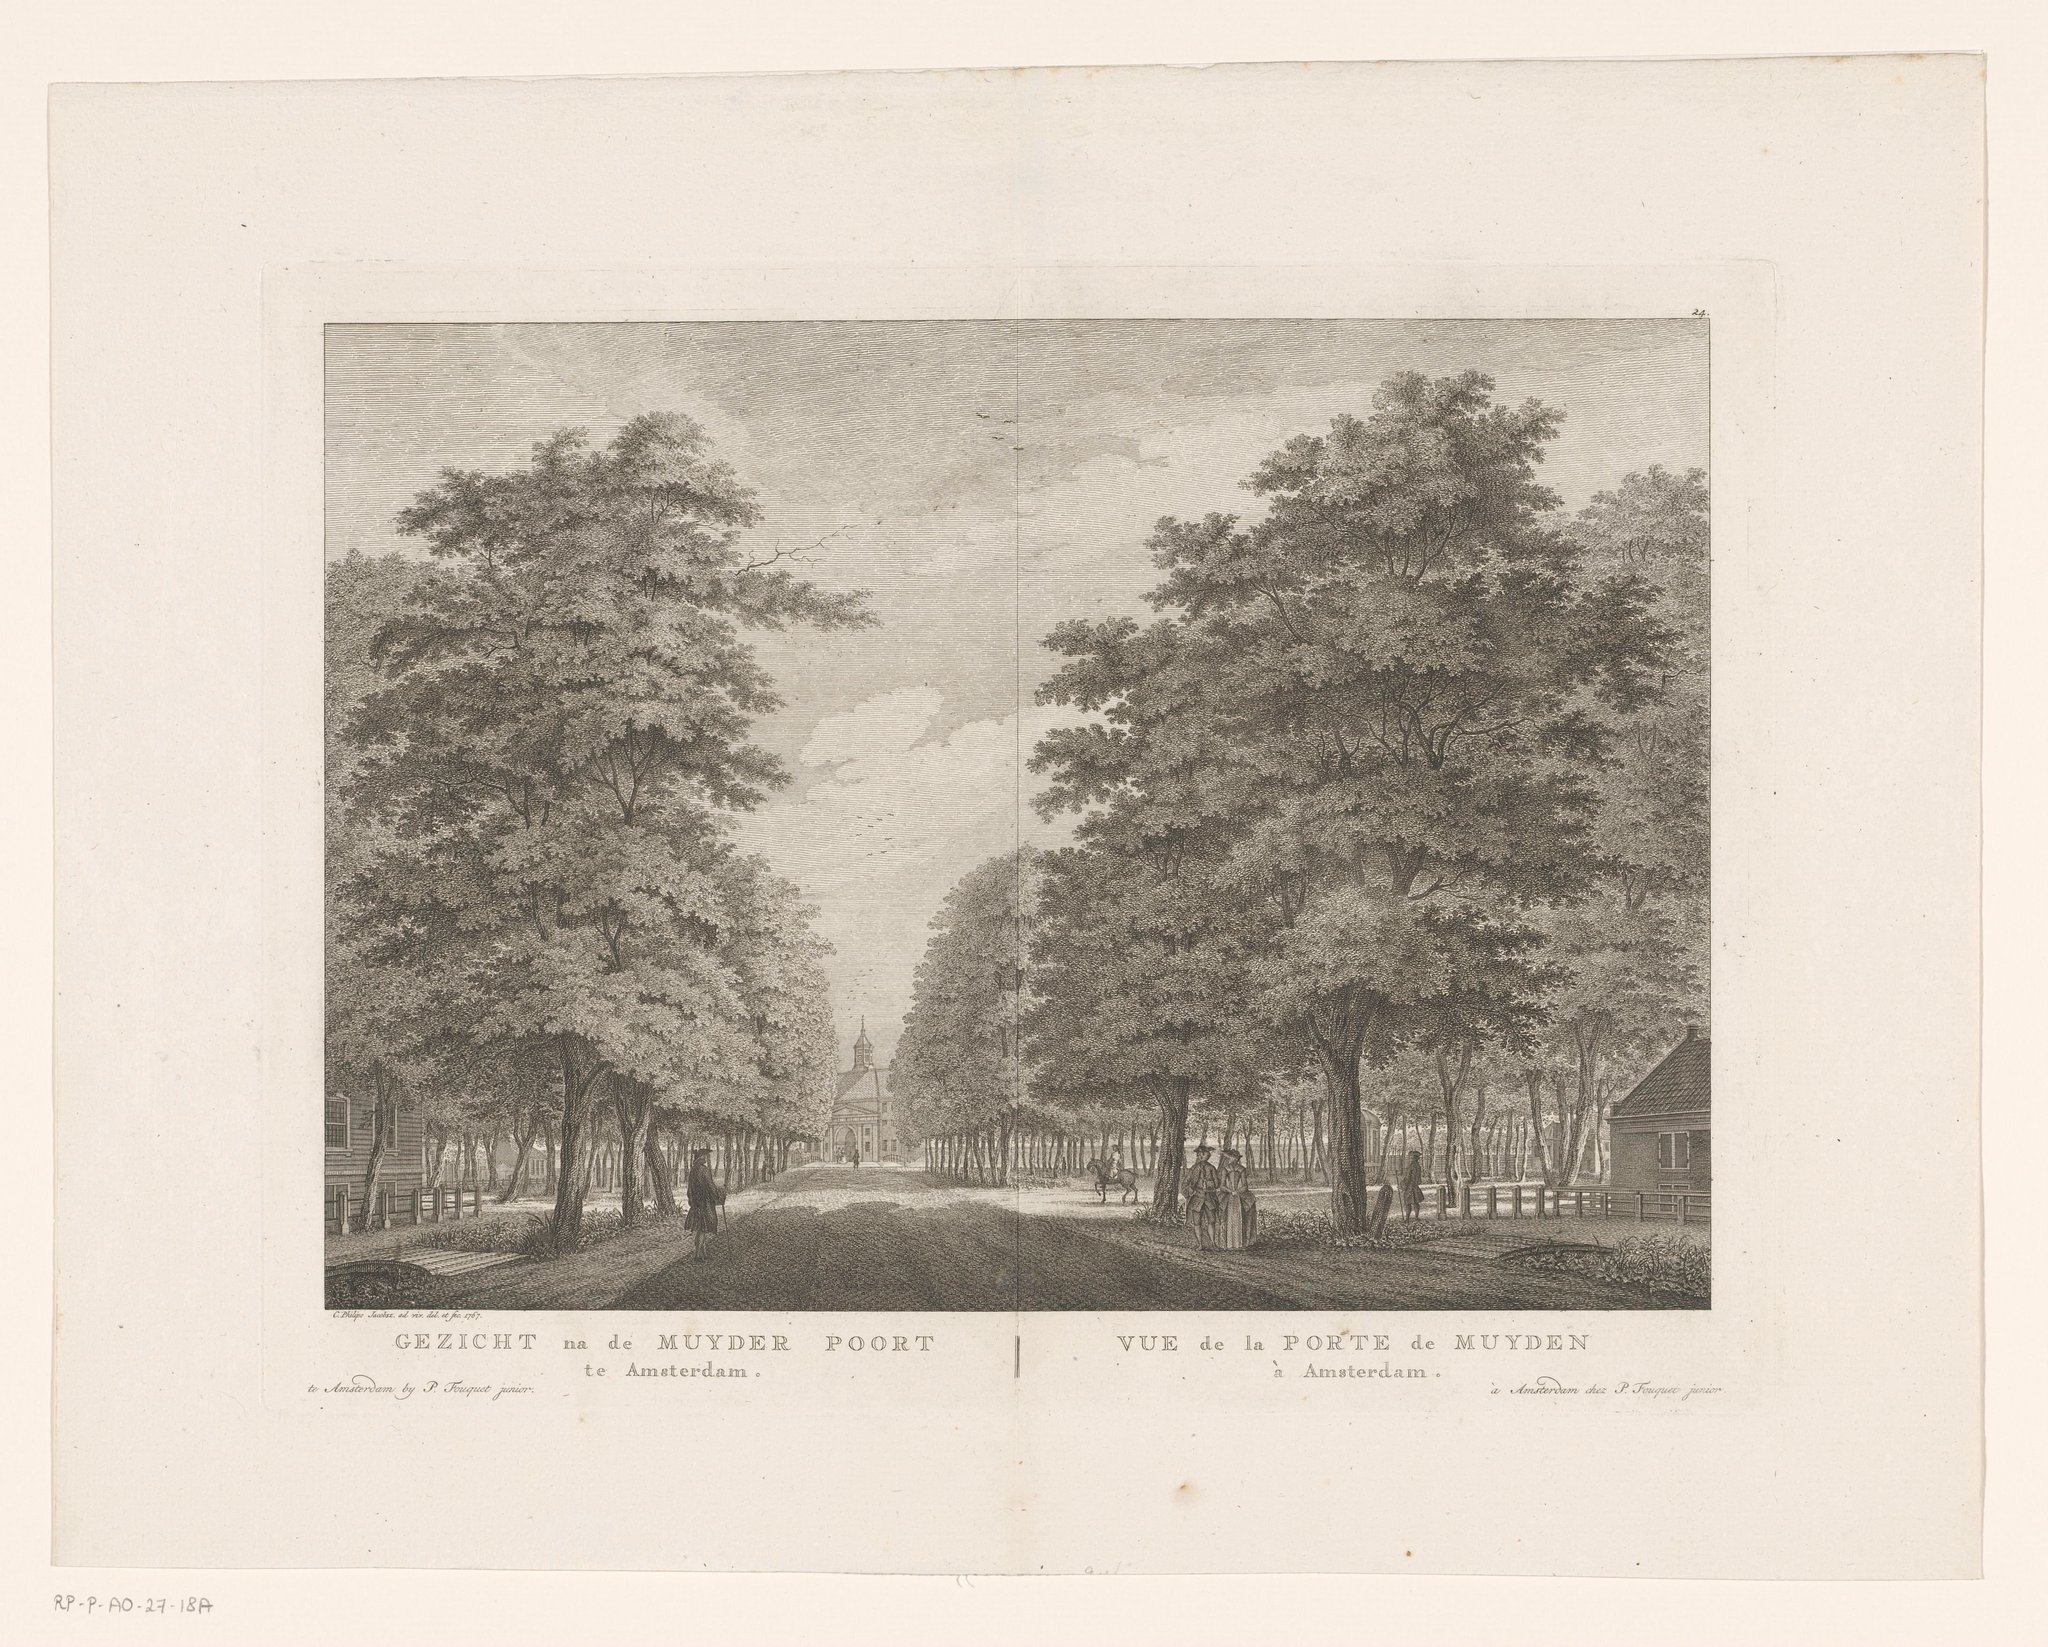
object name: print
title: Gezicht na de Muyder Poort te Amsterdam / Vue de la Porte de Muyden à Amsterdam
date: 1767-1783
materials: paper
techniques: engraving, etching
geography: amsterdam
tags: road, path, city-gate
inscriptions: collector's mark: Lugt 2228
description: Deze prent is ook gebruikt in de zogenaamde Atlas van Fouquet.* Pierre Fouquet gaf vanaf 1760 stadsgezichten van Amsterdam - naar tekeningen van verschillende kunstenaars, gemaakt door verschillende prentmakers - uit. Deze prenten werden aanvankelijk los of in series verkocht. Zoals toen gebruikelijk kon de koper de prenten zelf laten inbinden. Hiertoe gaf Fouquet tussen 1778 en 1783 een titelblad, plattegrond en inhoudsopgave van de tot dusver 100 uitgegeven prenten uit (1). Gezien de inhoud afhankelijk was van wat de koper had verzameld verschilt de inhoud van de verschillende bewaarde Fouquetatlassen onder deze titel sterk. Ook zijn er exemplaren bekend waar tevens andere prenten aan zijn toegevoegd. Omdat er behoefte bleek aan uitleg bij de platen werd in 1783 een nieuwe versie van de atlas uitgegeven, aangevuld met tekst en twee prenten. De aangegeven volgorde veranderde maar de platen van de al eerder uitgegeven prenten bleven ongewijzigd. Deze uitgave werd in opdracht van Fouquet gedrukt bij Daniël Jean Changuion en Petrus den Hengst (2). Een tiental platen werd bijgewerkt en verscheen, met nieuw impressum, in het vervolg van Wagenaars geschiedenis van Amsterdam, uitgeven door Petrus Conradi en Folkert van der Plaats (3). Een aantal jaar na het overlijden van Fouquet kwam Evert Maaskamp met een nieuwe uitgave van de atlas, met verbeterde tekst en toevoeging van twee prenten. Op alle platen verwijderde hij het oude en liet hij zijn eigen impressum zetten (4). De huidige staat van de prent komt voor in exemplaren van de onder (1) en (2) genoemde werken. * Onder de Atlas van Fouquet of Fouquetatlas verstaan we de hieronder vermelde publicaties (1), (2) en (4). (1). Afbeeldingen van de wyd-vermaarde koopstad Amsterdam benevens des zelvs voornaamste gebouwen en gezigten alle naar het leeven getekend / Receuil des edifices les plus considerables et des plus belles vues, de la fameuse ville d'Amsterdam, dessinées d'après nature. Amsterdam: Pierre Fouquet, 1778-1783. (2). Nieuwe atlas, van de voornaamste gebouwen en gezigten der stad Amsterdam, met derzelver beknopte beschryvingen. 2 delen. Amsterdam: Daniël Jean Changuion en Petrus den Hengst [in opdracht van Pierre Fouquet], 1783. (3). Stijl, Simon. Amsterdam, in zyne geschiedenissen, voorregten, koophandel, gebouwen, kerkenstaat, schoolen, schutterye, gilden en regeeringe, beschreeven. Om te dienen ten vervolge op het werk van Jan Wagenaar (…). 10 delen. Amsterdam en Harlingen: Petrus Conradi en Folkert van der Plaats, 1788-1801. (4). Nieuwe atlas, van de voornaamste gebouwen en gezigten der stad Amsterdam. Met derzelver beknopte beschryvingen. Amsterdam: Evert Maaskamp, 1805. * Het aantal vermelde staten is gebaseerd op het aantal gevonden staten. Mogelijk zijn er meer staten van deze prent.